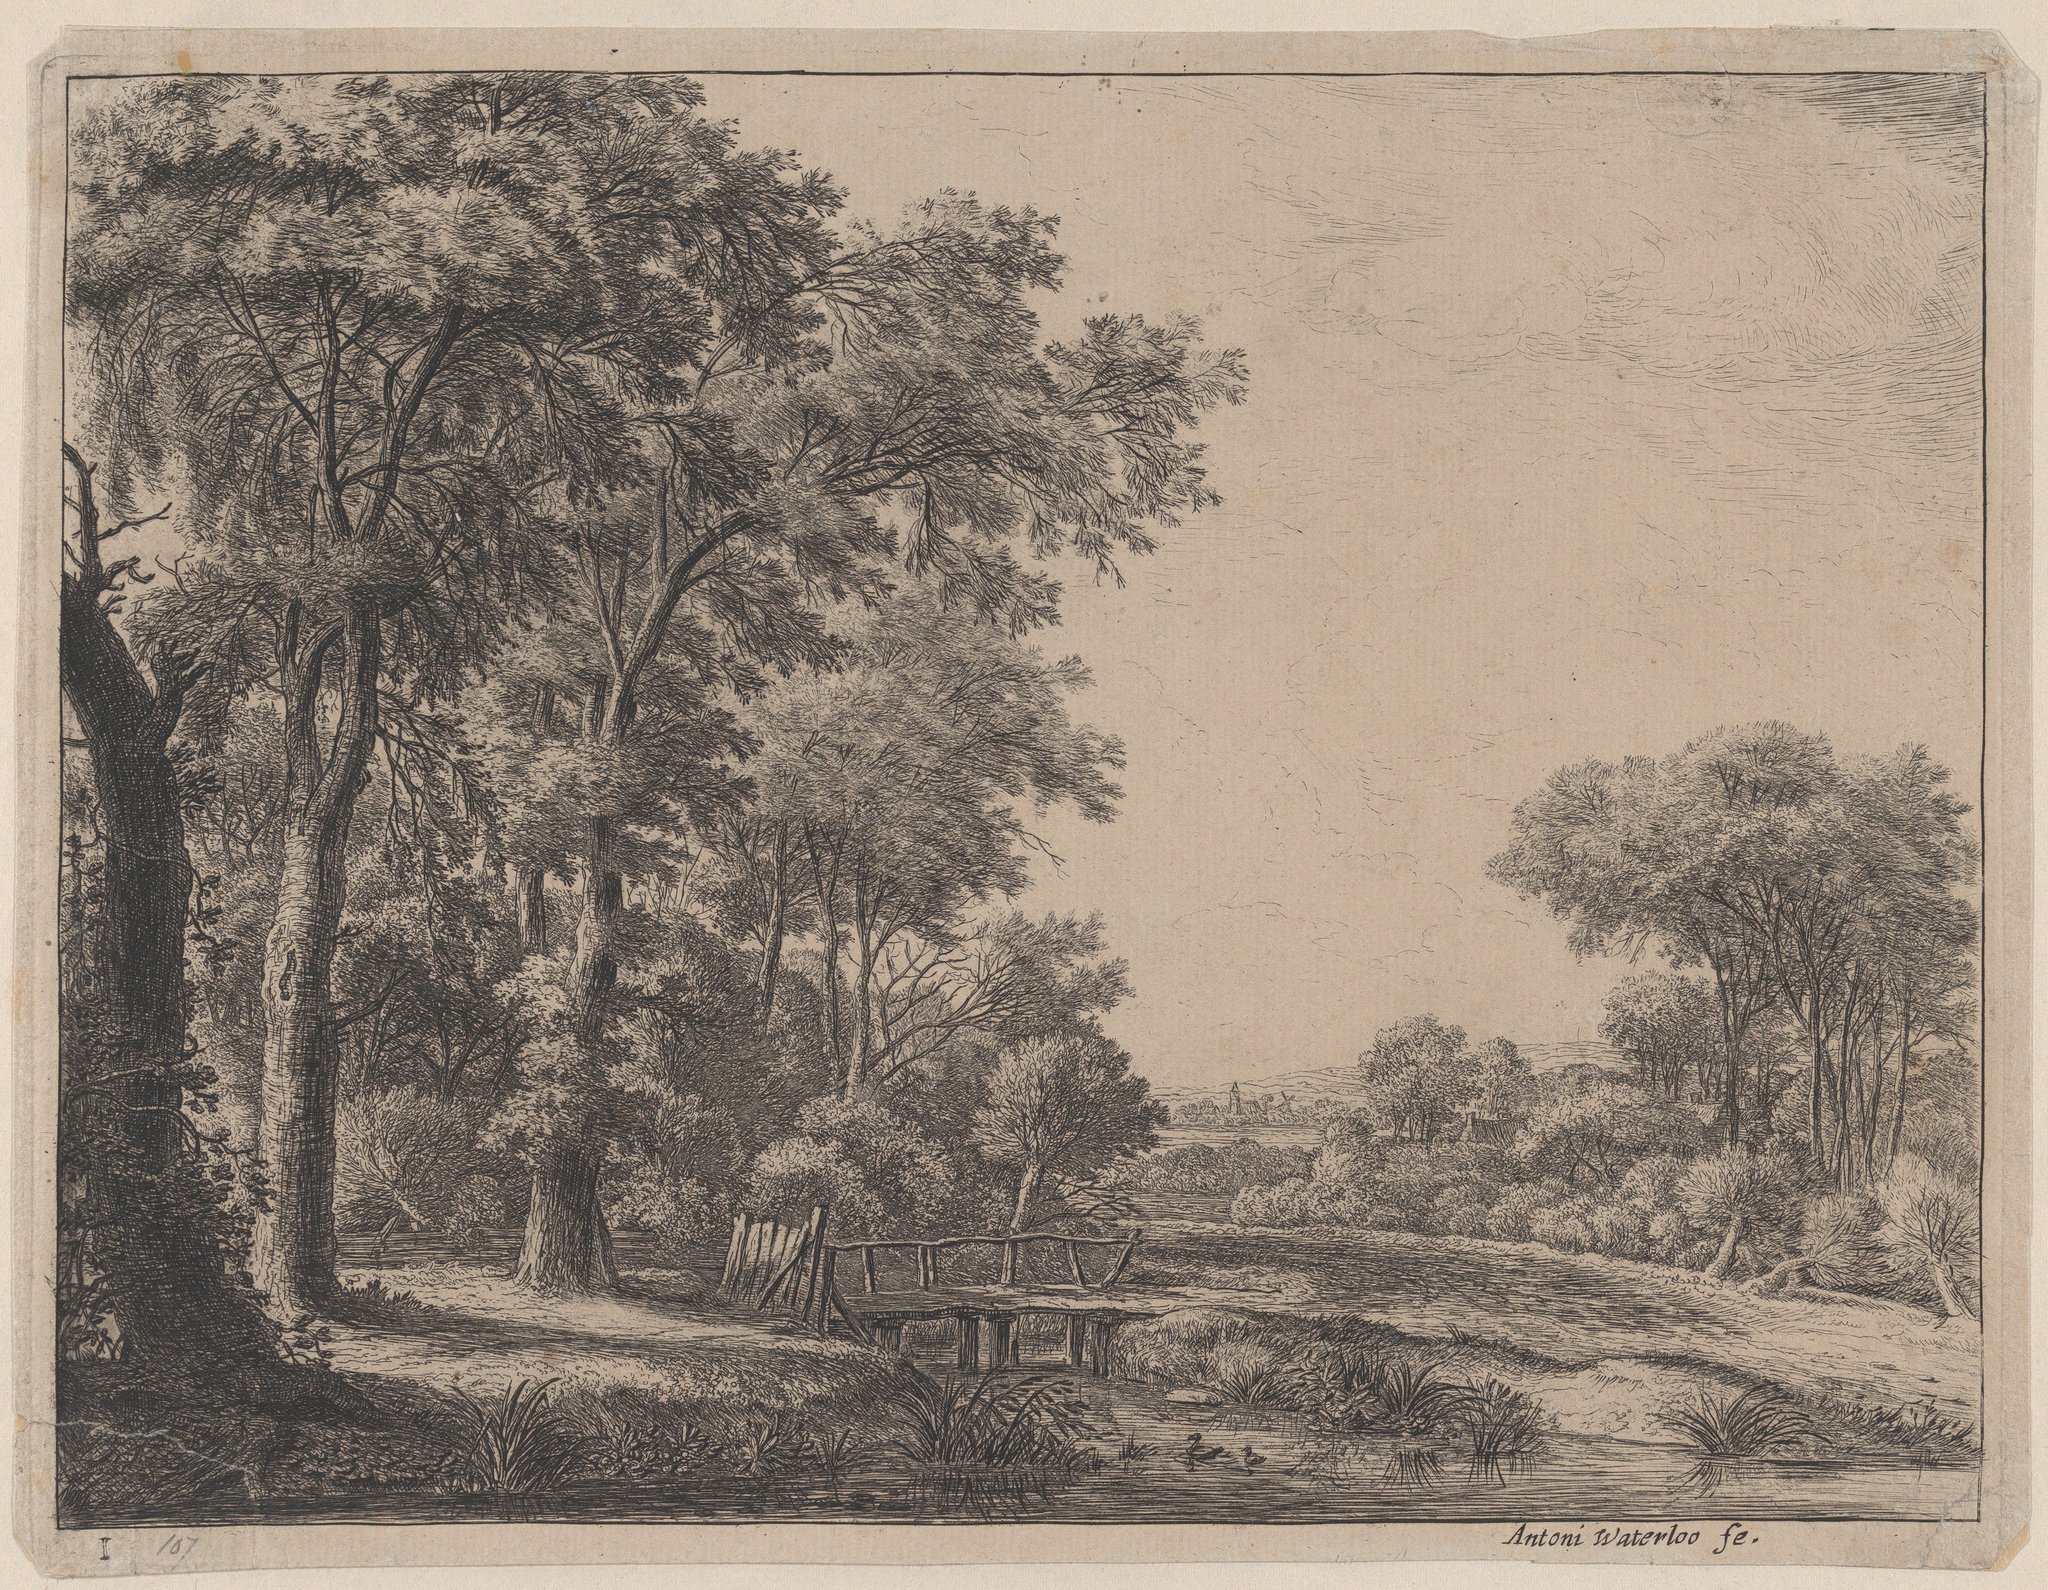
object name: print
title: The Entrance to a Forest by a Small Wooden Bridge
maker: anthonie waterloo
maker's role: artist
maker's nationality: dutch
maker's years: 1609-1690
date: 1601-1700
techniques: etching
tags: bridges,forests